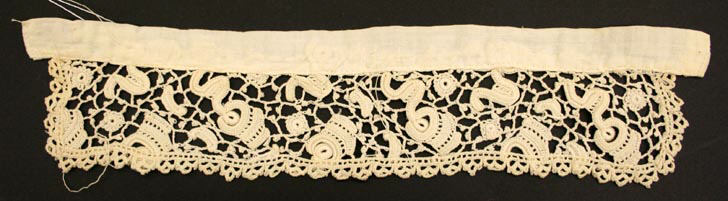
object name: collar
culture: american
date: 1700-1941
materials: cotton